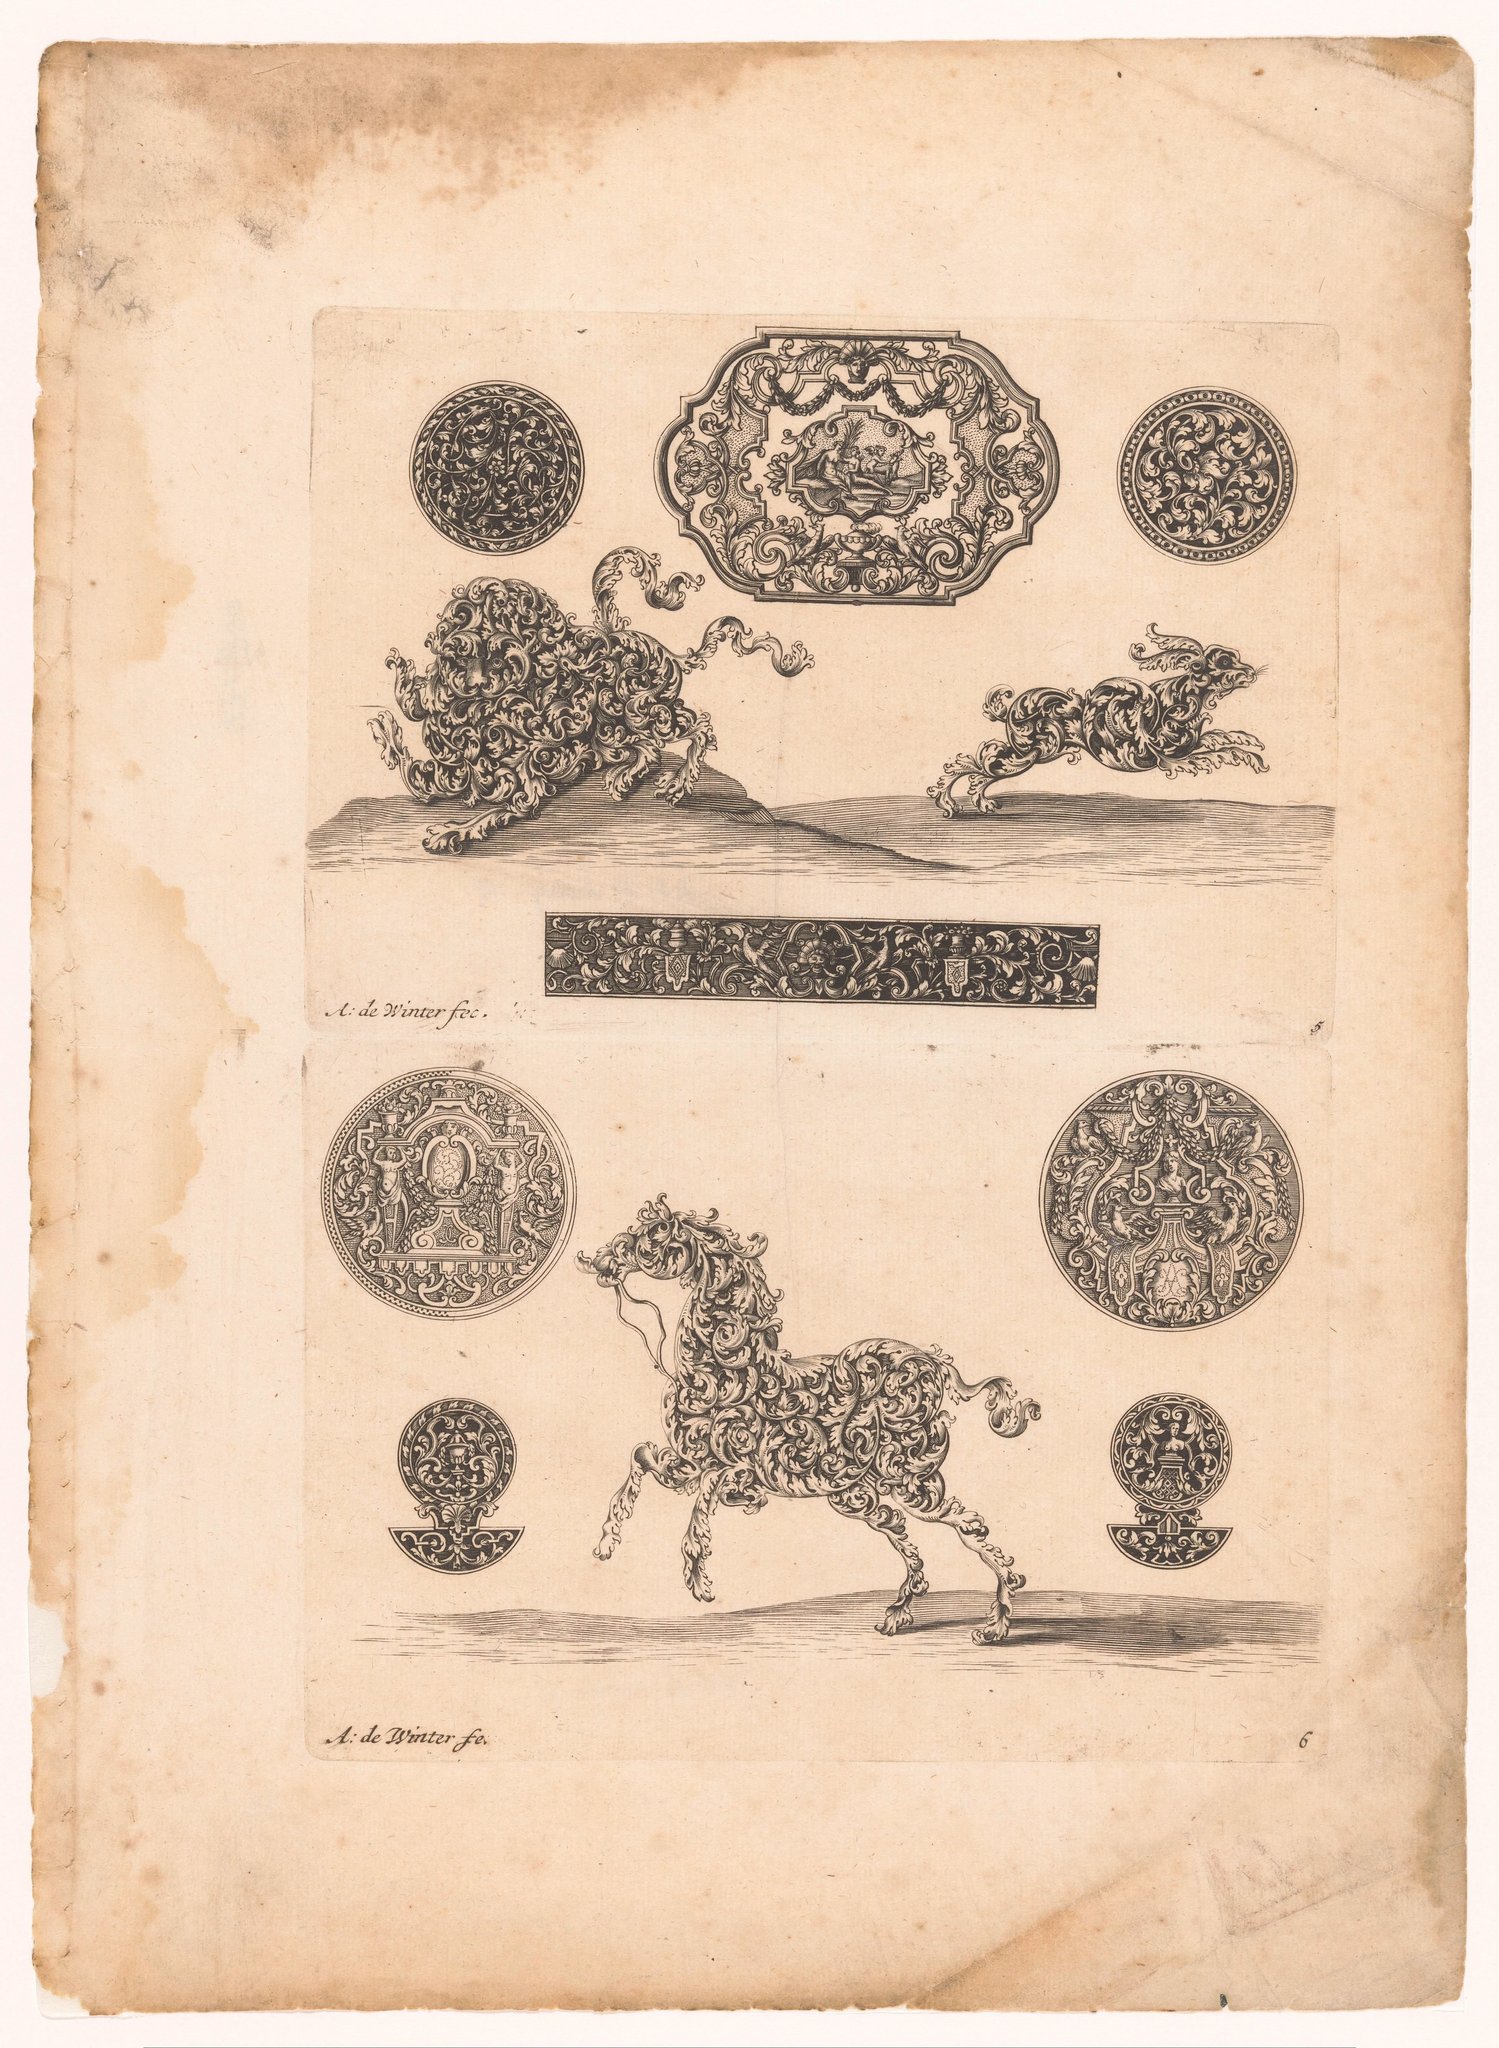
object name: ornament print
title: Leeuwen, haas en een paard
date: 1698-1707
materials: paper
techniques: engraving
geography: netherlands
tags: animal interlace ~ ornament, rodents: hare, horse, beasts of prey, predatory animals: lion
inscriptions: collector's mark: Lugt 2228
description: Twee prenten op een blad. Modellen voor edelsmeden van dieren en figuren samengesteld uit bladornamenten, aangevuld met modellen voor juwelen. Boven: Links liggen twee leeuwen naast elkaar op een heuvel, rechts een springende haas. Onder: Een steigerend paard.